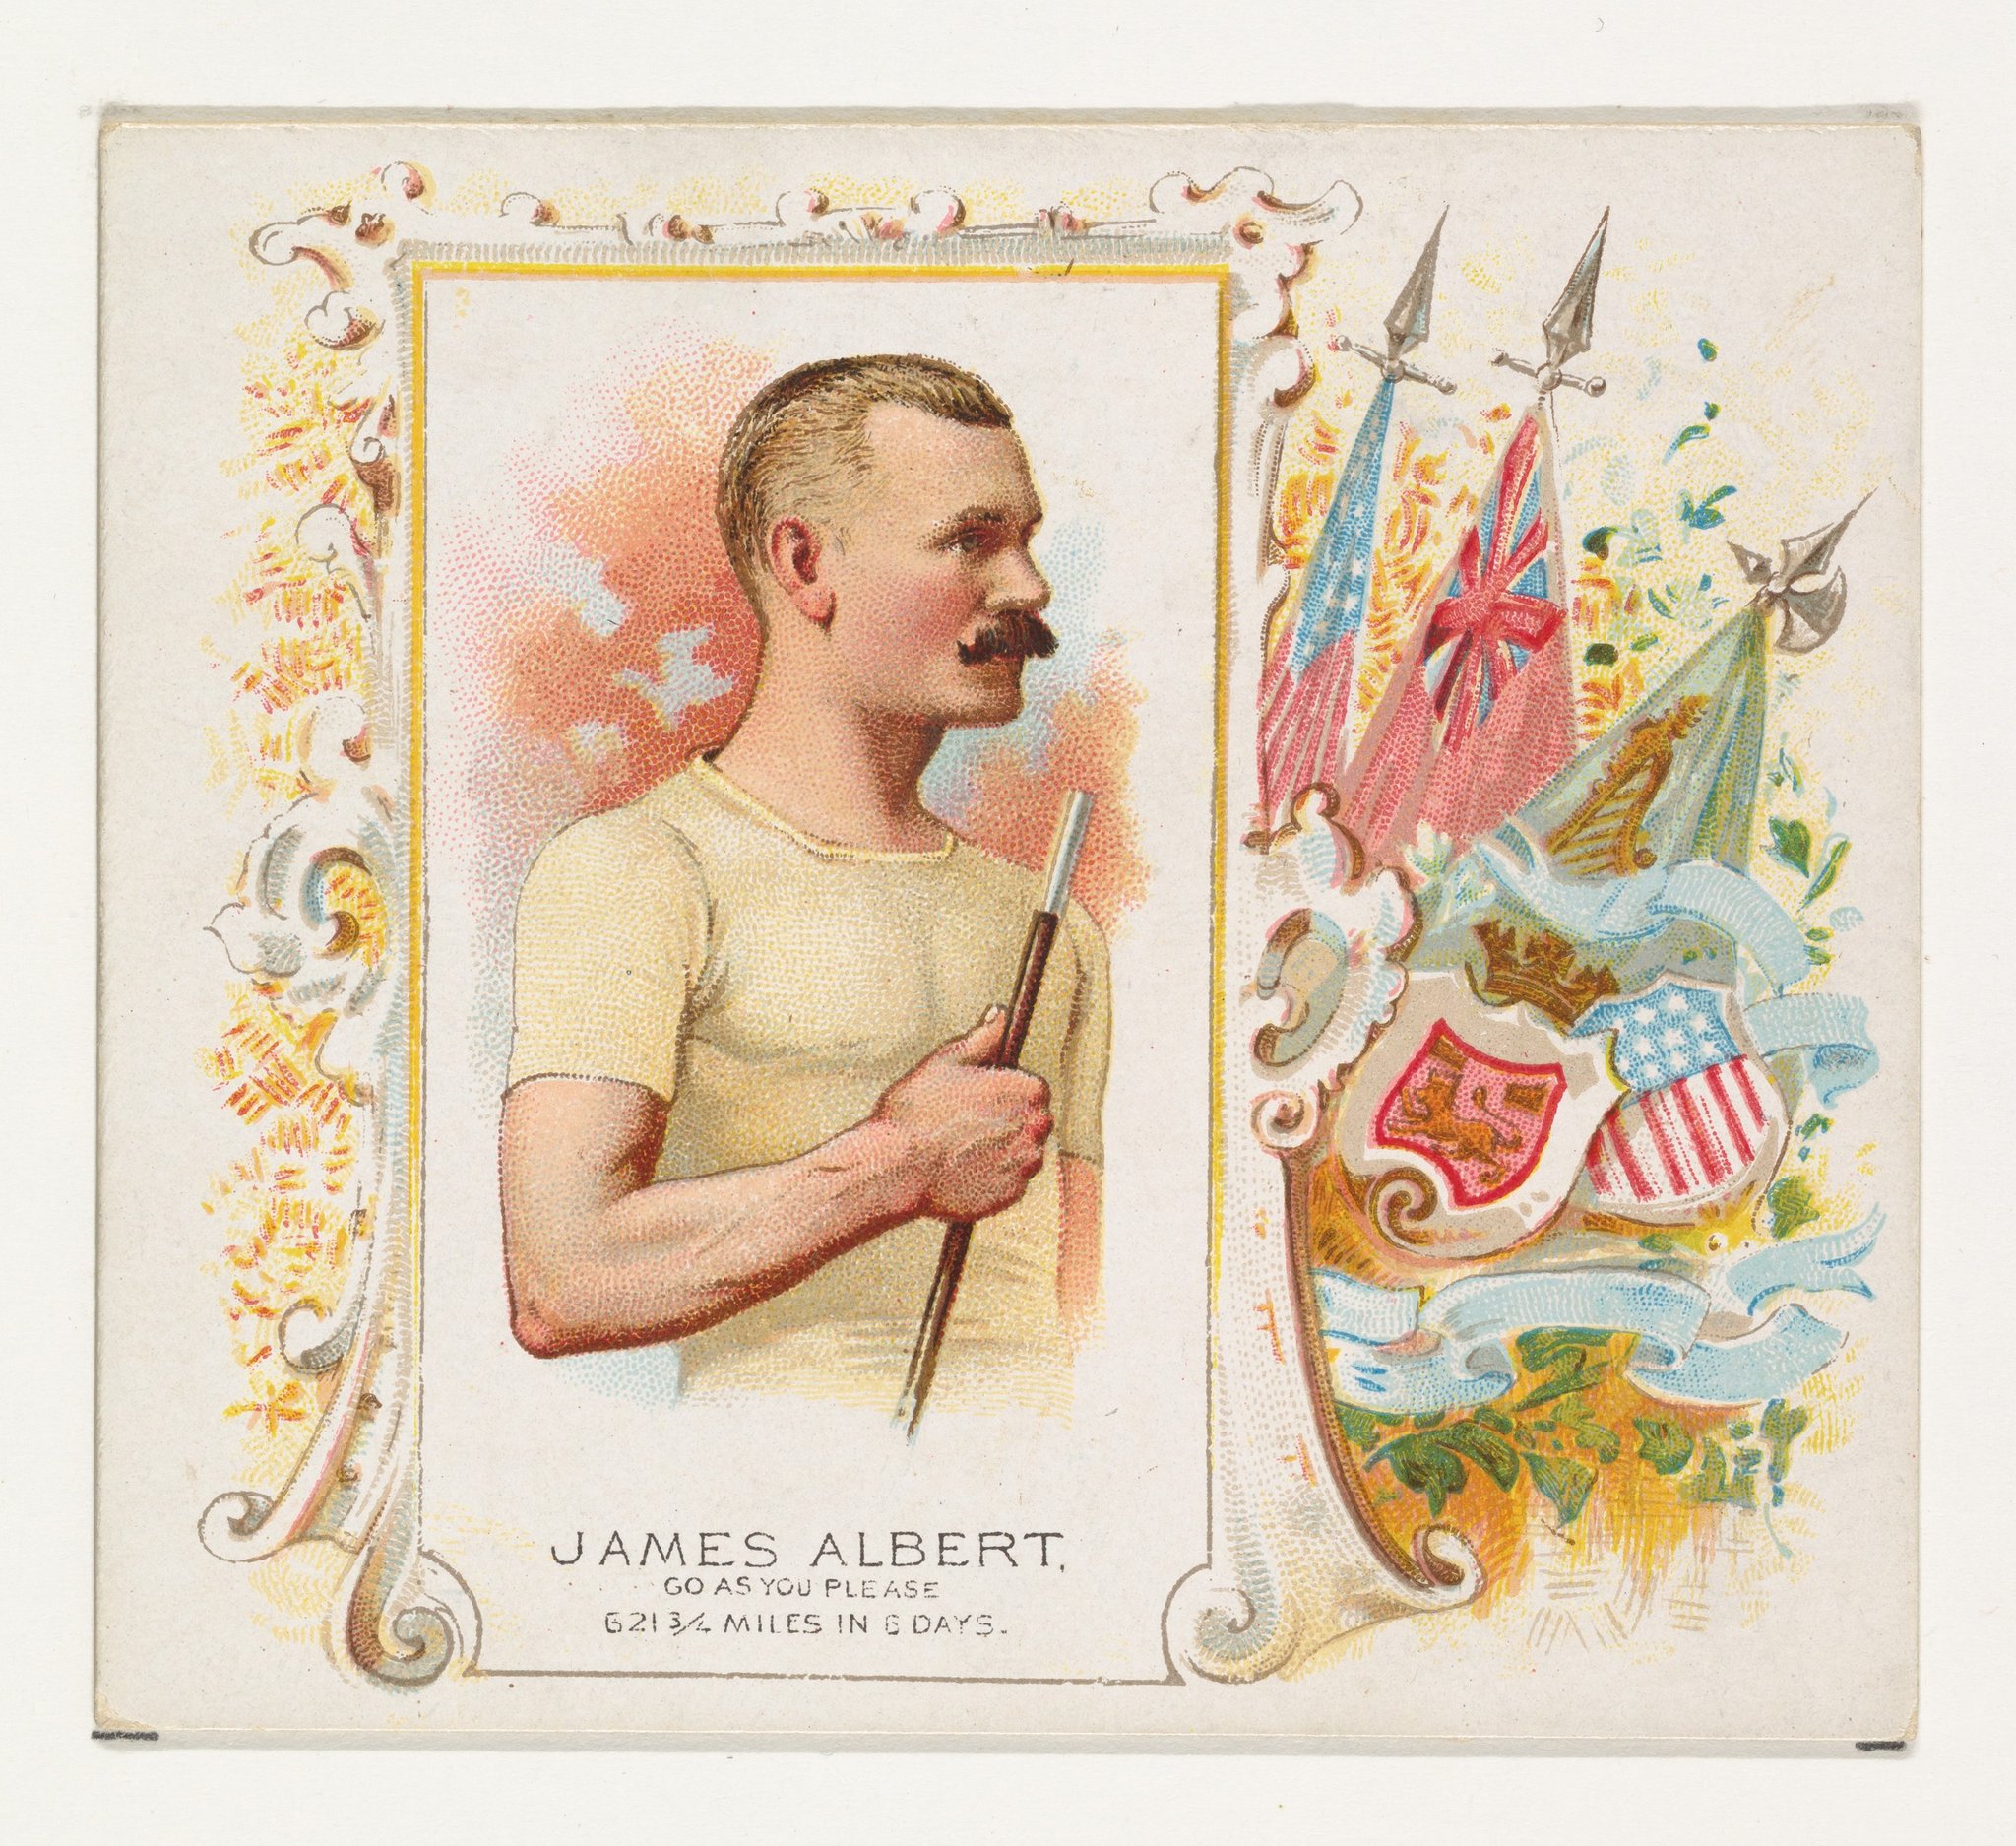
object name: print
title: James Albert, Go As You Please, from World's Champions, Second Series (N43) for Allen & Ginter Cigarettes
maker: allen & ginter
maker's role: publisher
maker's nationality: american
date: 1888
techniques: lithography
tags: men,profiles,athletes